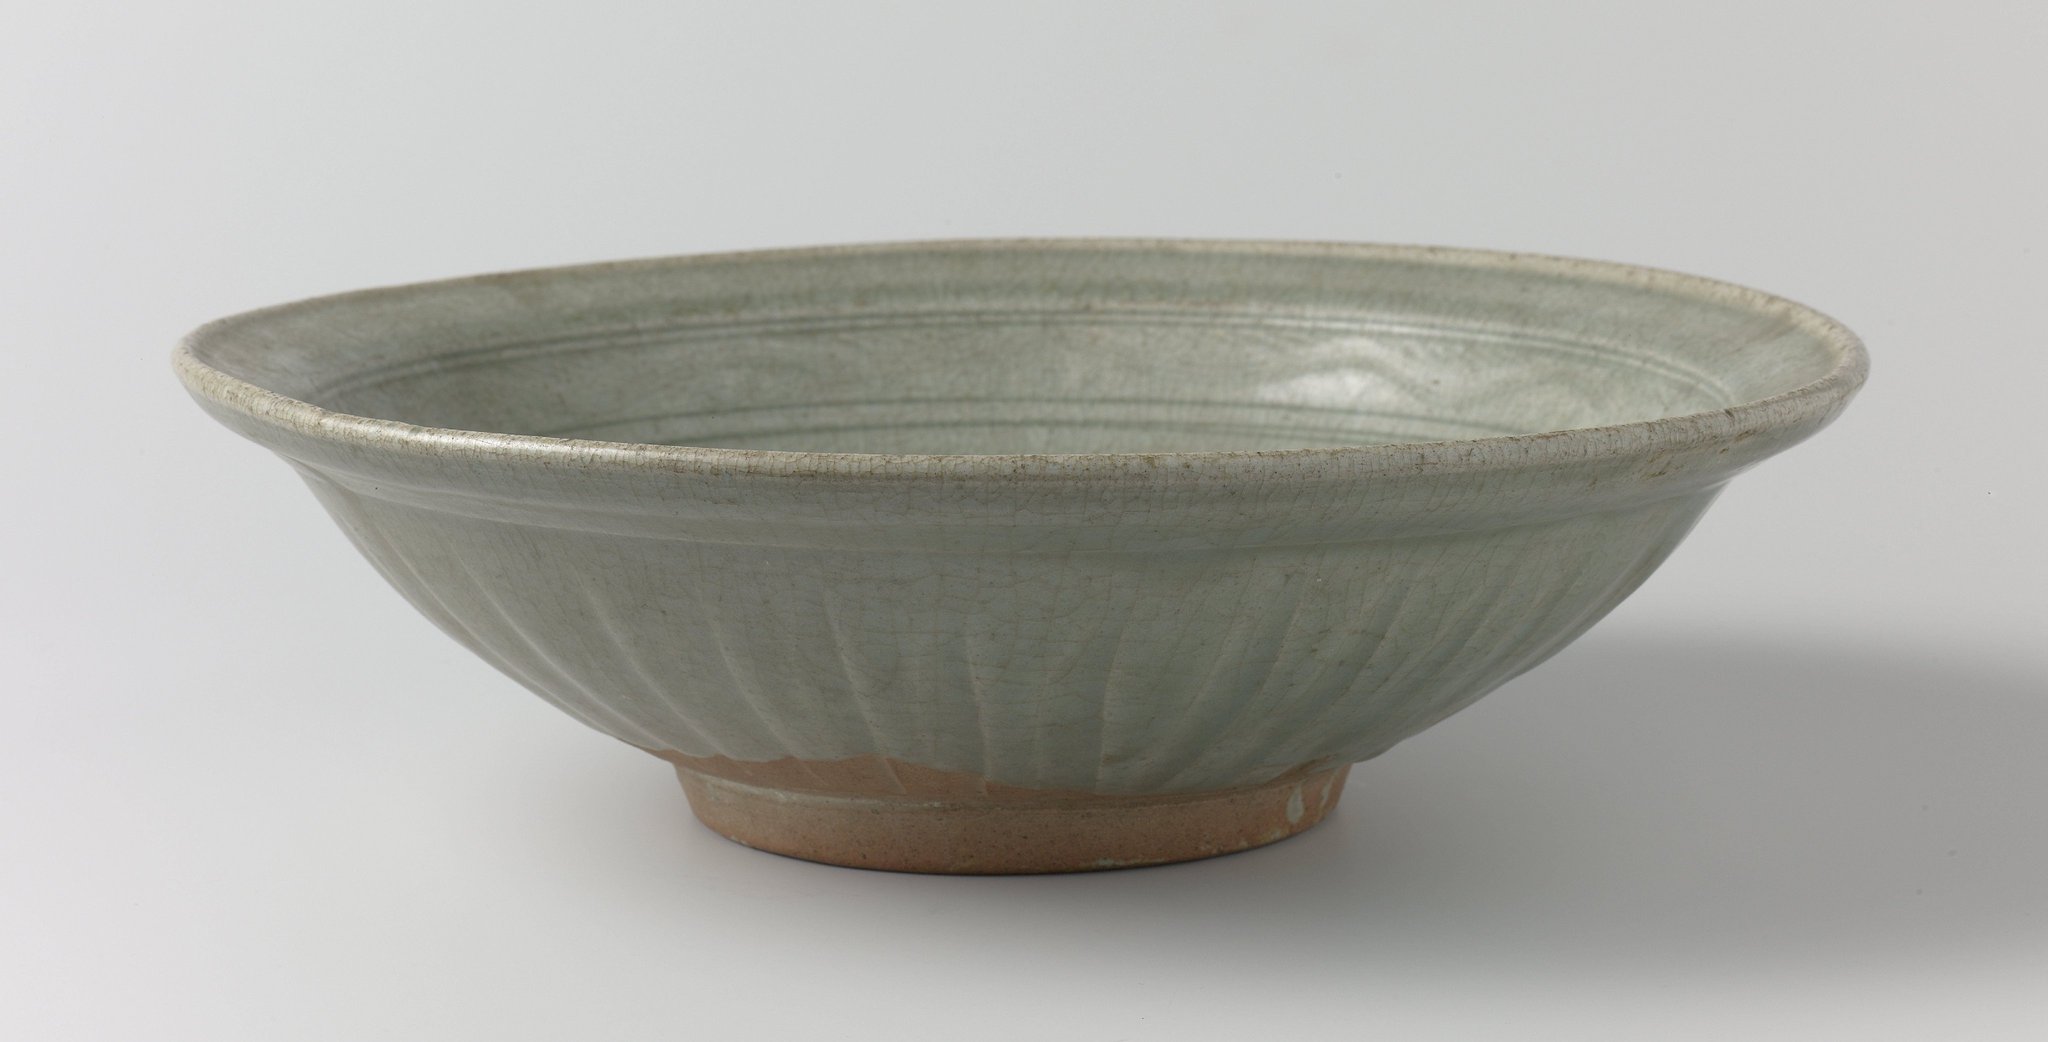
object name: dish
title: Ribbed saucer-dish with an incised decoration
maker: Anonymous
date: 1300-1500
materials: glaze, stoneware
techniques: engraving, firing, forming, turning, vitrification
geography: sawankhalok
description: Schaal van steengoed met een geribde wand, gedeeltelijk bedekt met een groen glazuur. Het onderste deel is ongeglazuurd. Op de voorzijde ingegrifte cirkels en een ingegrifte band met een golvende lijn. Celadon.